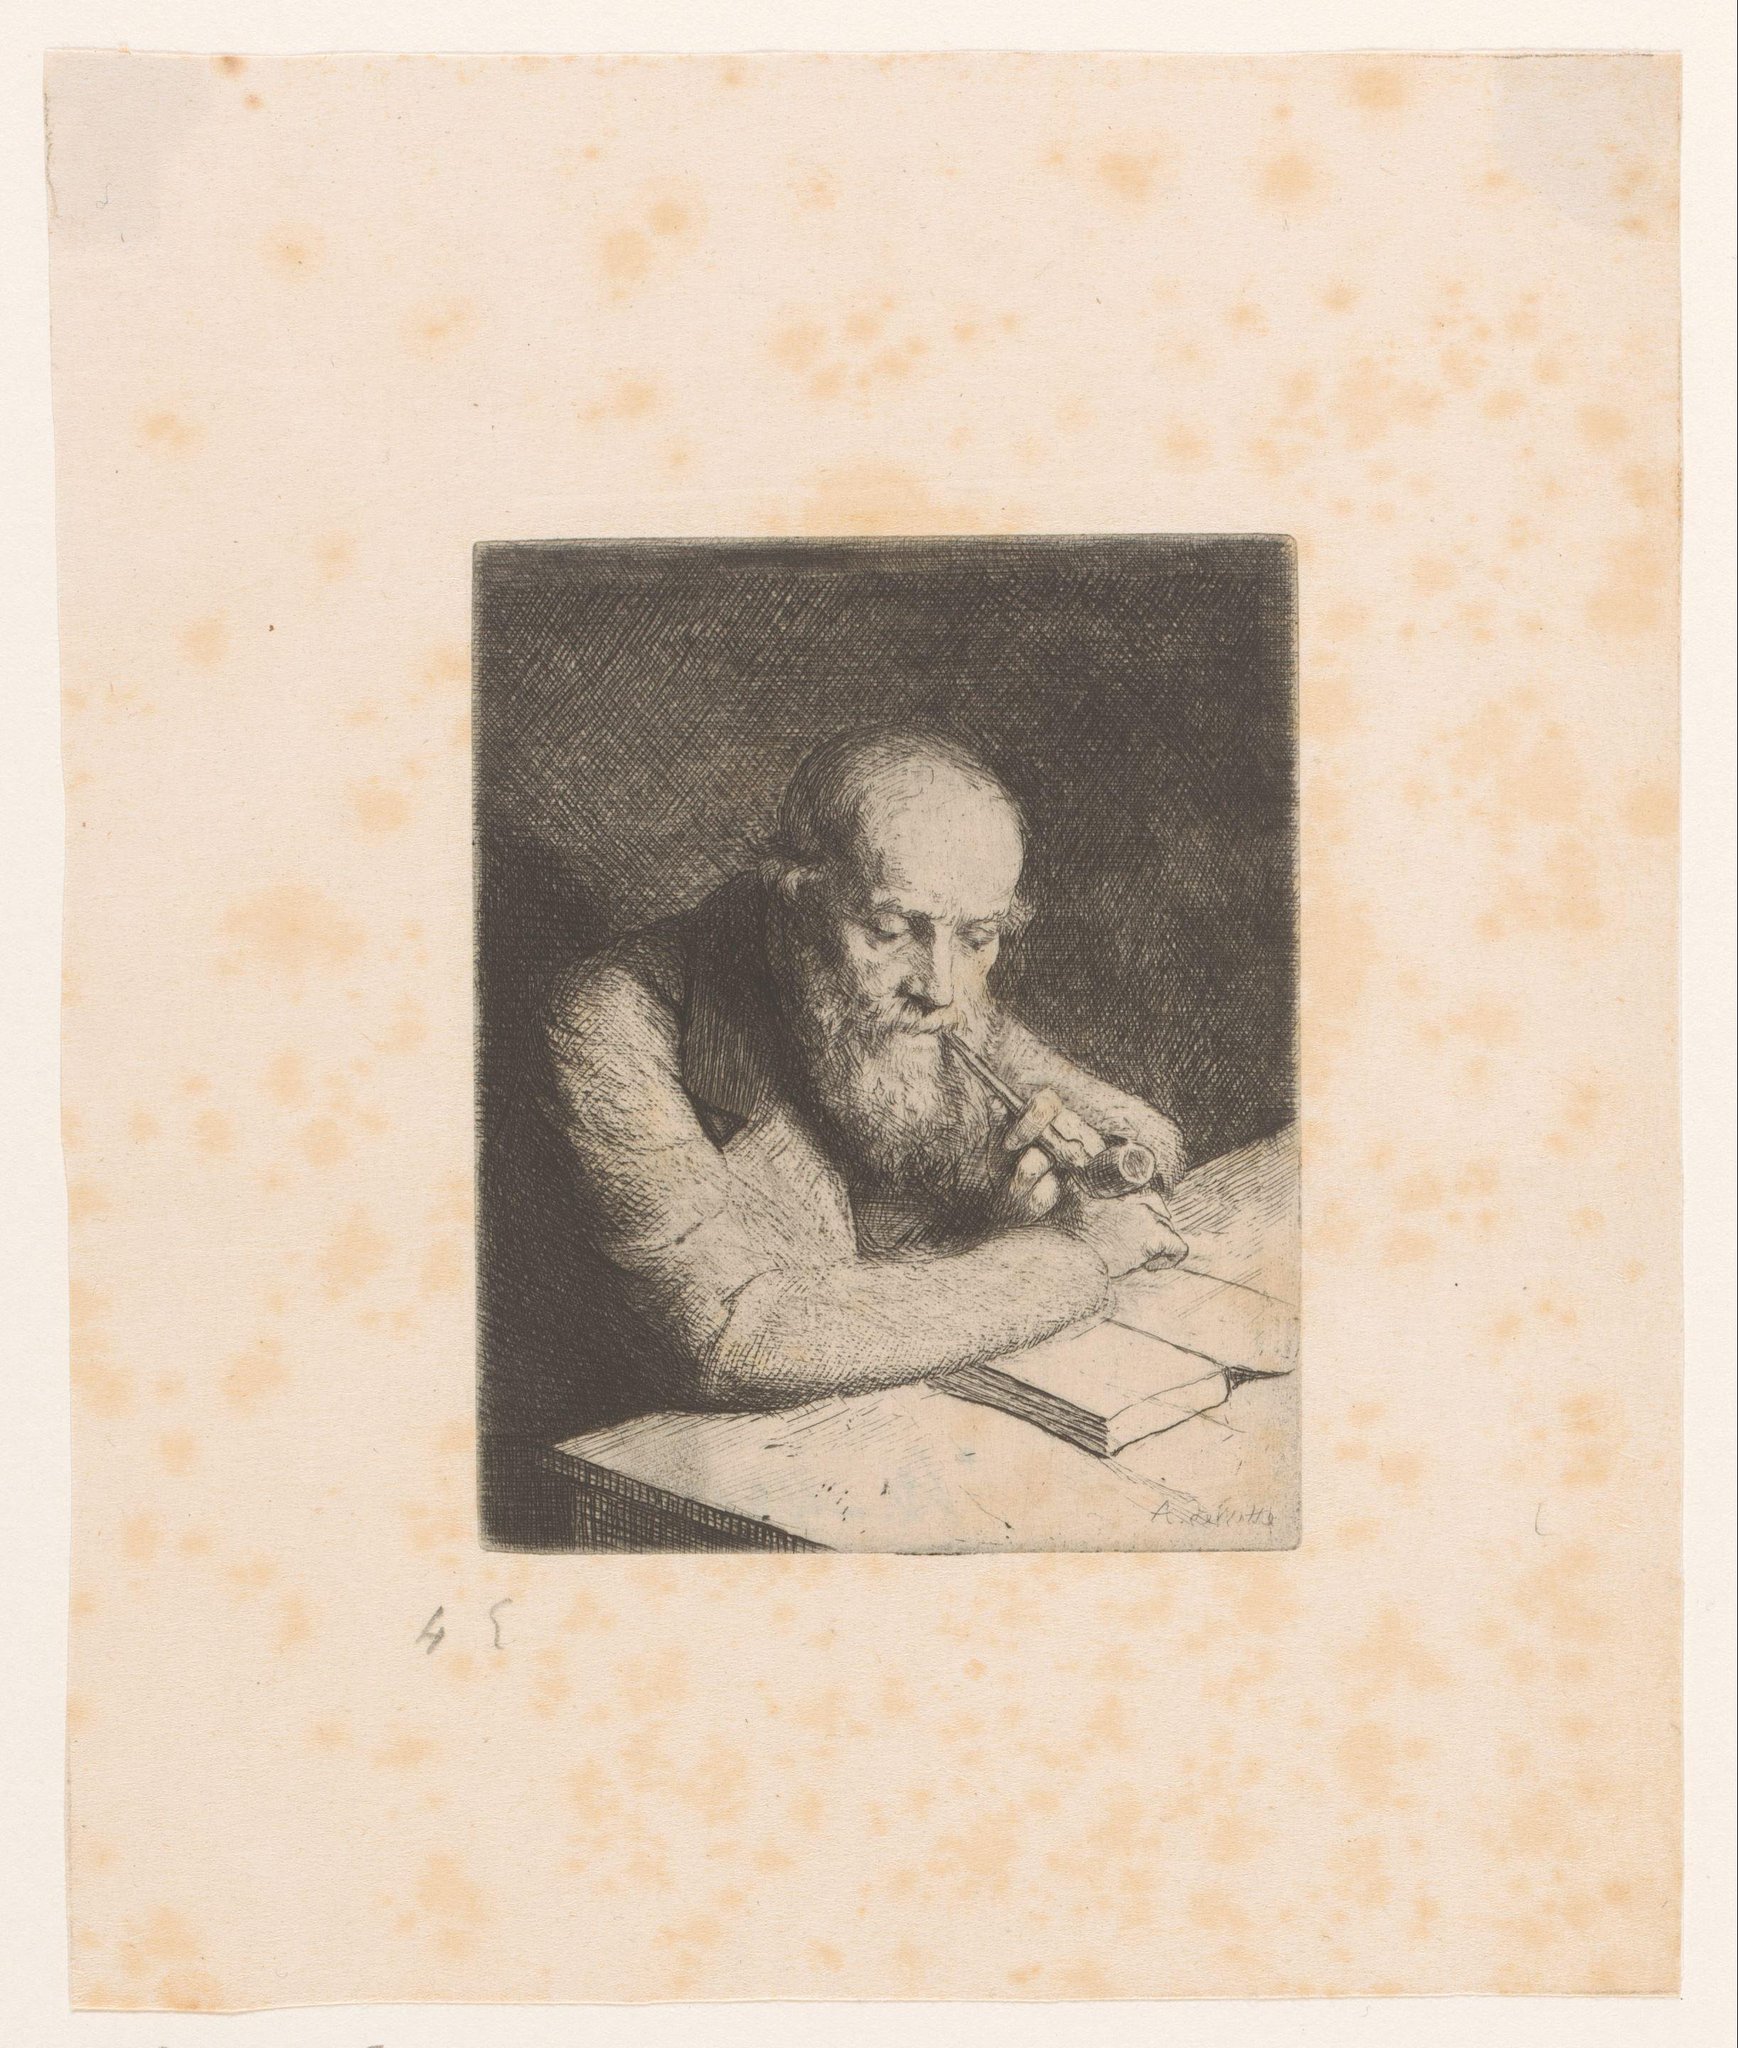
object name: print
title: Pijprokende oude man met boek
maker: adrien de witte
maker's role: print maker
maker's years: 1850-1935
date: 1860-1913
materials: paper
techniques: drypoint, etching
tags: pipe ~ tobacco, book - mm - book open, old man, beard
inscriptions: collector's mark: Lugt 2228